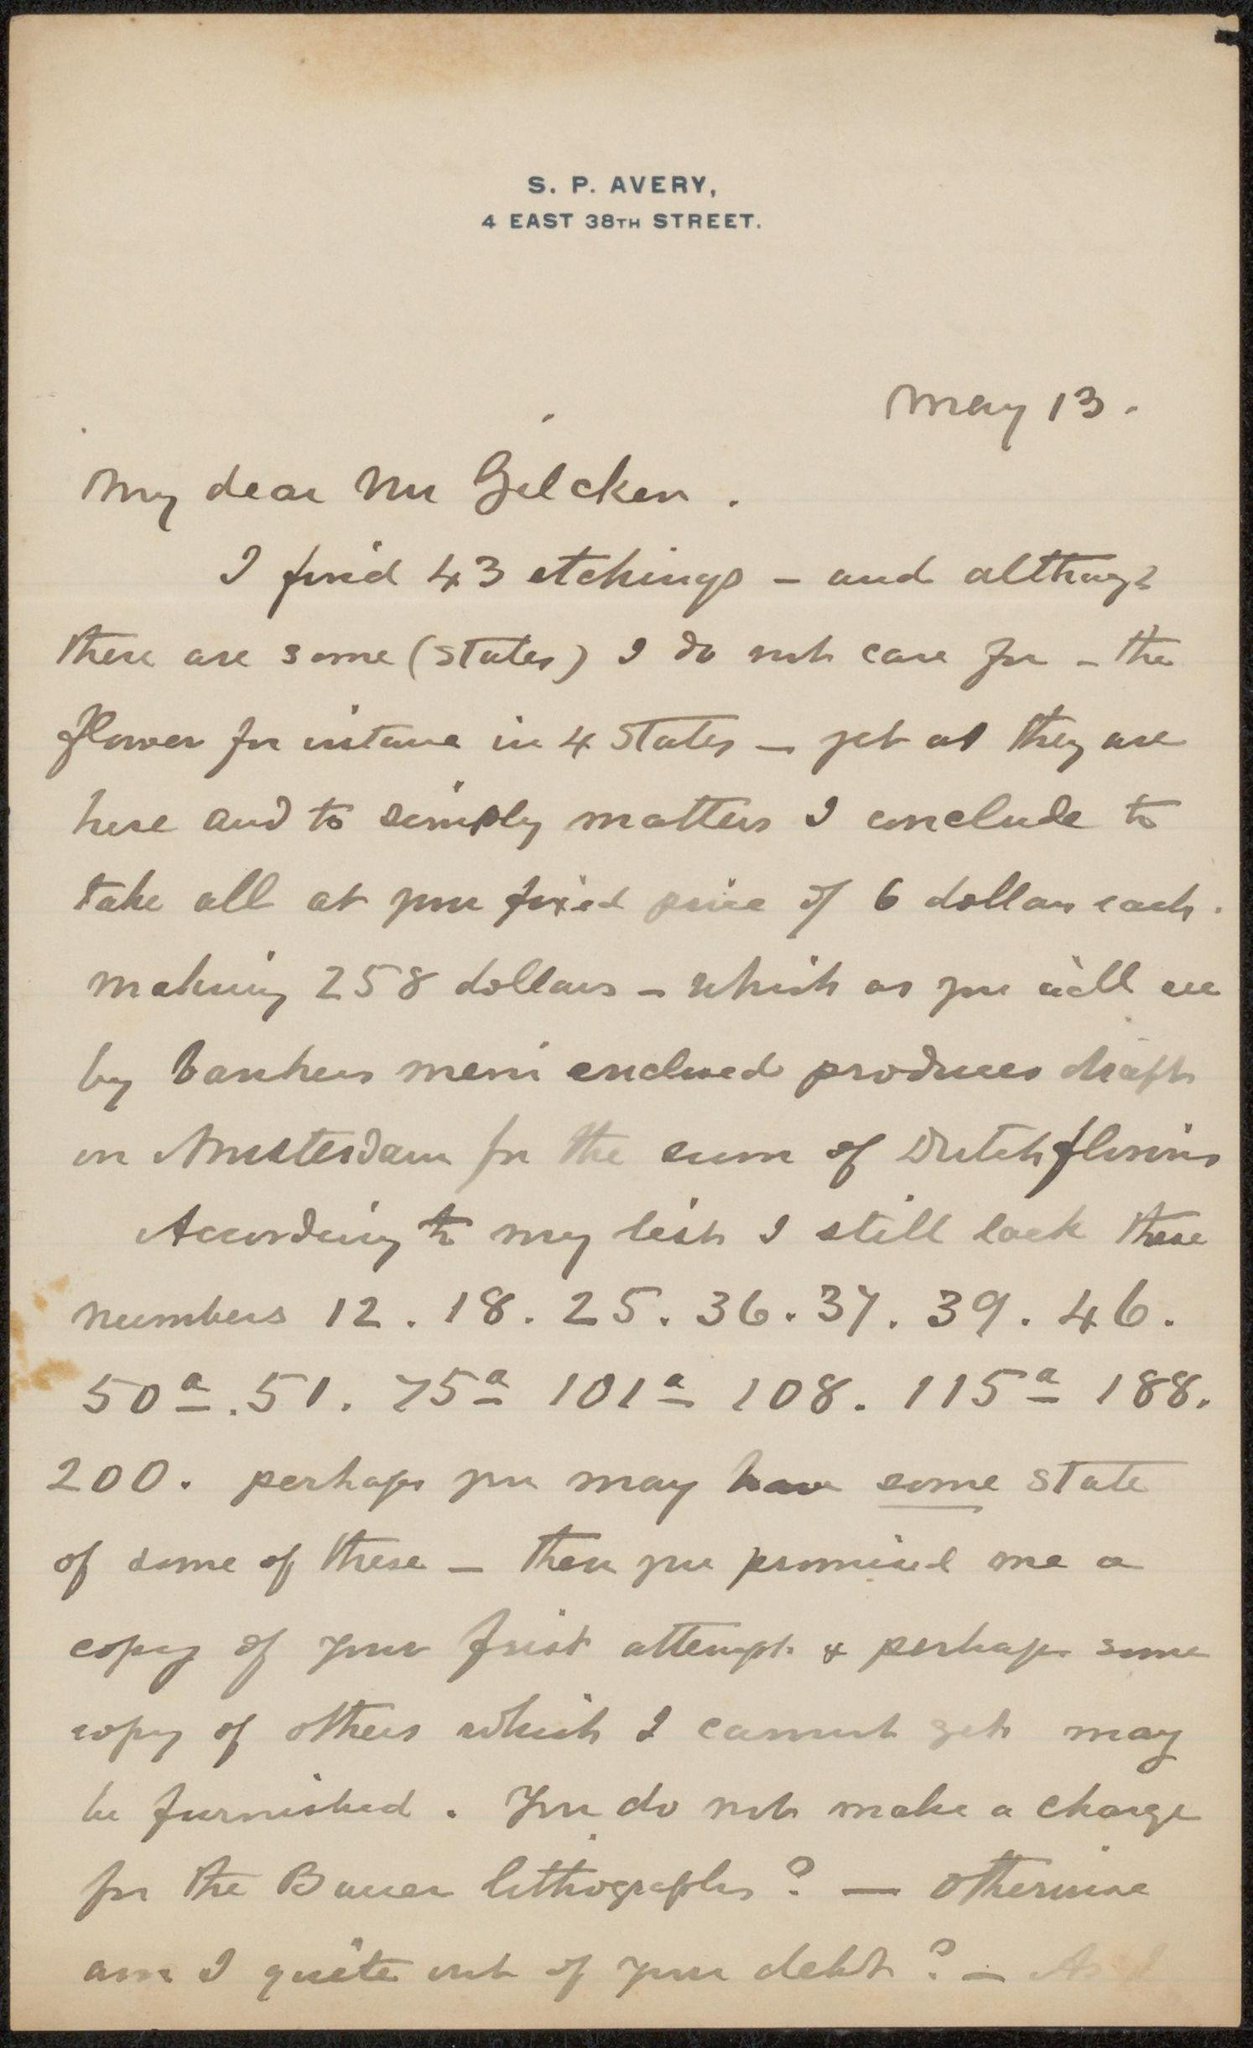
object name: letter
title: Brief aan Philip Zilcken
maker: samuel putnam avery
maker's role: verzamelaar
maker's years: 1822-1904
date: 1832-1904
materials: ink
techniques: pen, printing, writing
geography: new york city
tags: print maker, marius bauer, elbert jan van wisselingh, the hague, painter, draughtsman, philip zilcken, art trade, art shop, the graphic arts, art collecting, temporary exhibition, 'salon', london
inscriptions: collector's mark: ‘RPK’